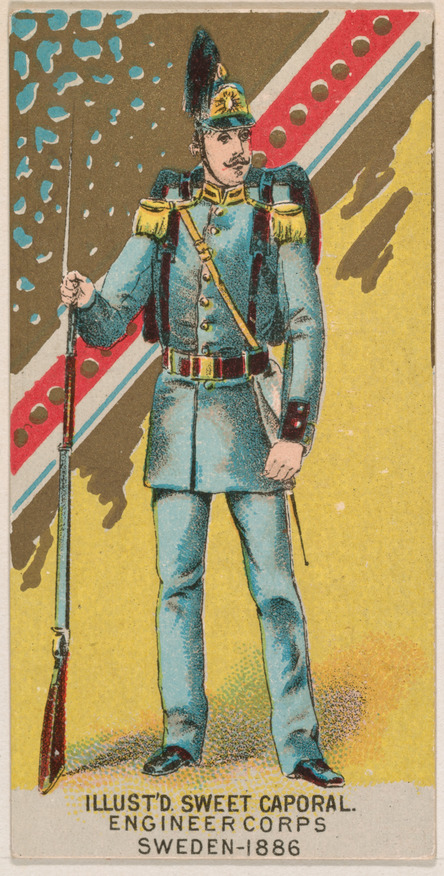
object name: print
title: Engineer Corps, Sweden, 1886, from the Military Series (N224) issued by Kinney Tobacco Company to promote Sweet Caporal Cigarettes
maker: kinney brothers tobacco company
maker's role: publisher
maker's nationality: american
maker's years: 1869-2011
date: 1888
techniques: color lithograph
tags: military,firearms,men